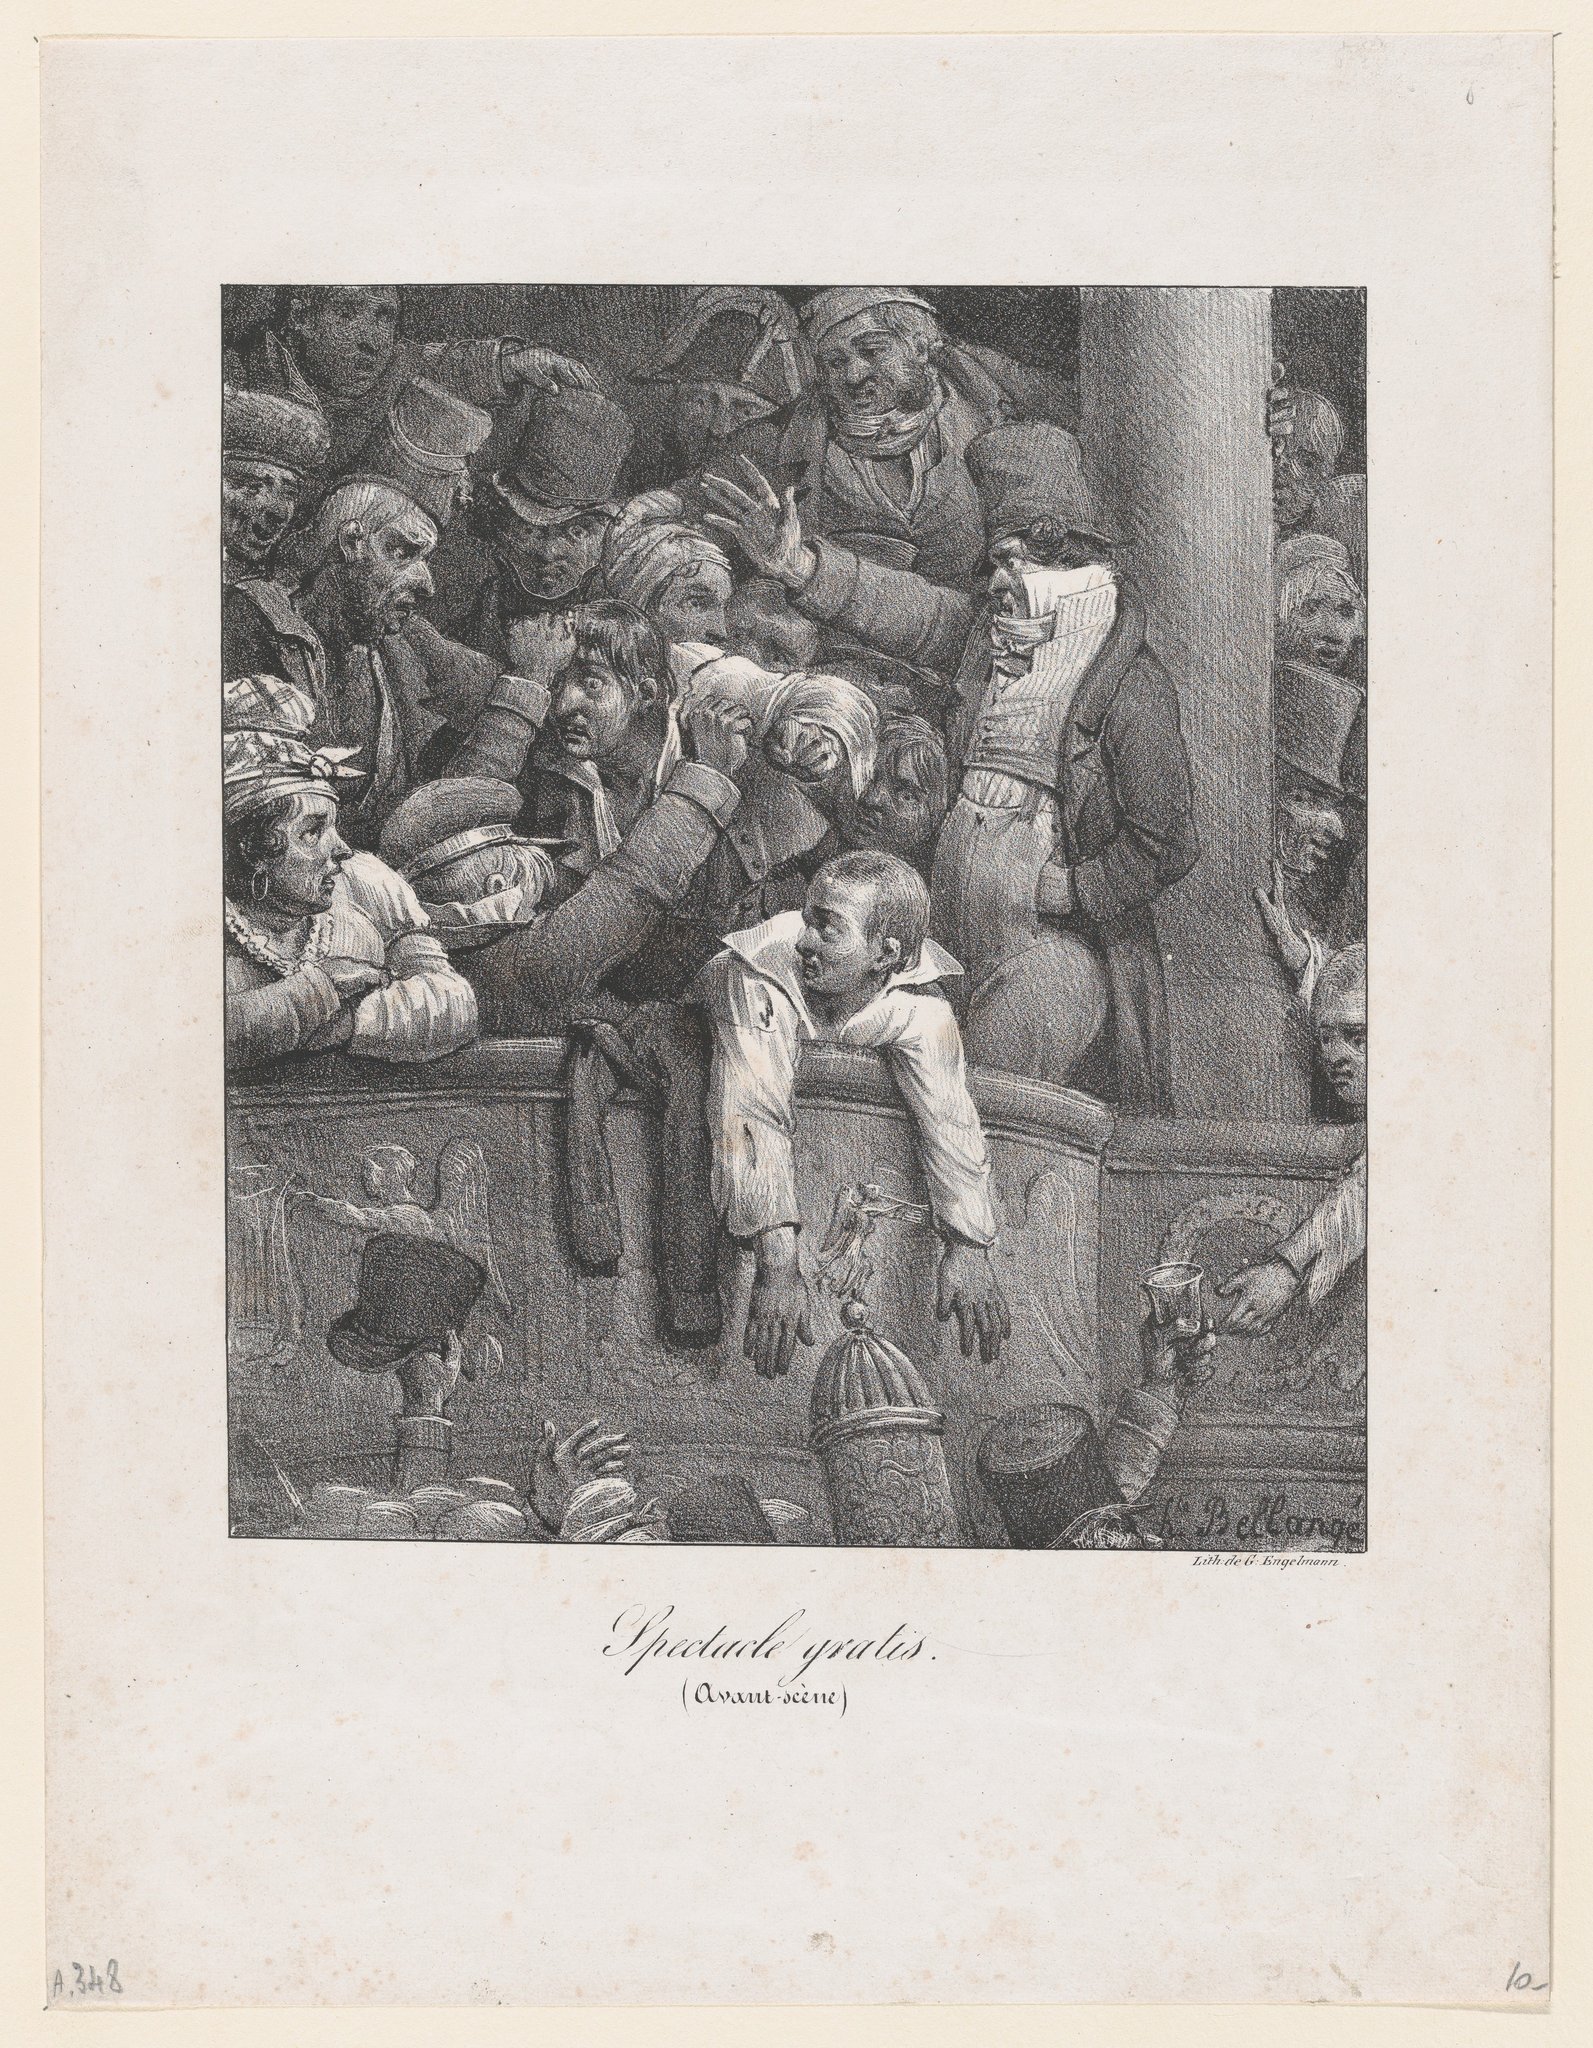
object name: print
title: Free Performance (Loge closest to the stage)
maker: hippolyte bellangé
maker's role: artist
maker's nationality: french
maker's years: 1800-1866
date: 1830-1840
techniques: lithograph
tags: performance,men,women,spectators